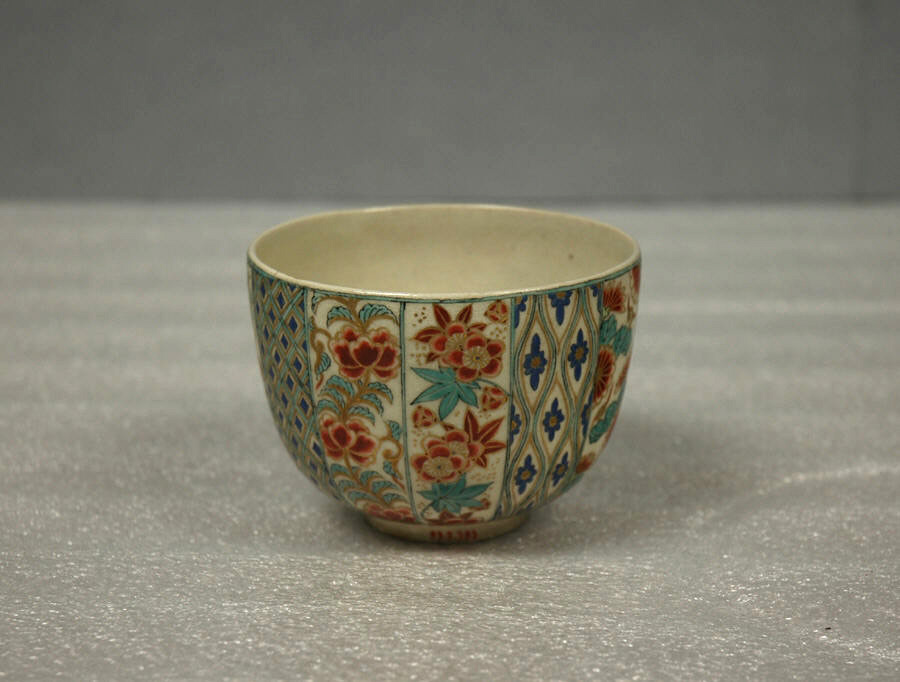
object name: cup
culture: japanese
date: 1820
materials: clay, glaze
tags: leaves